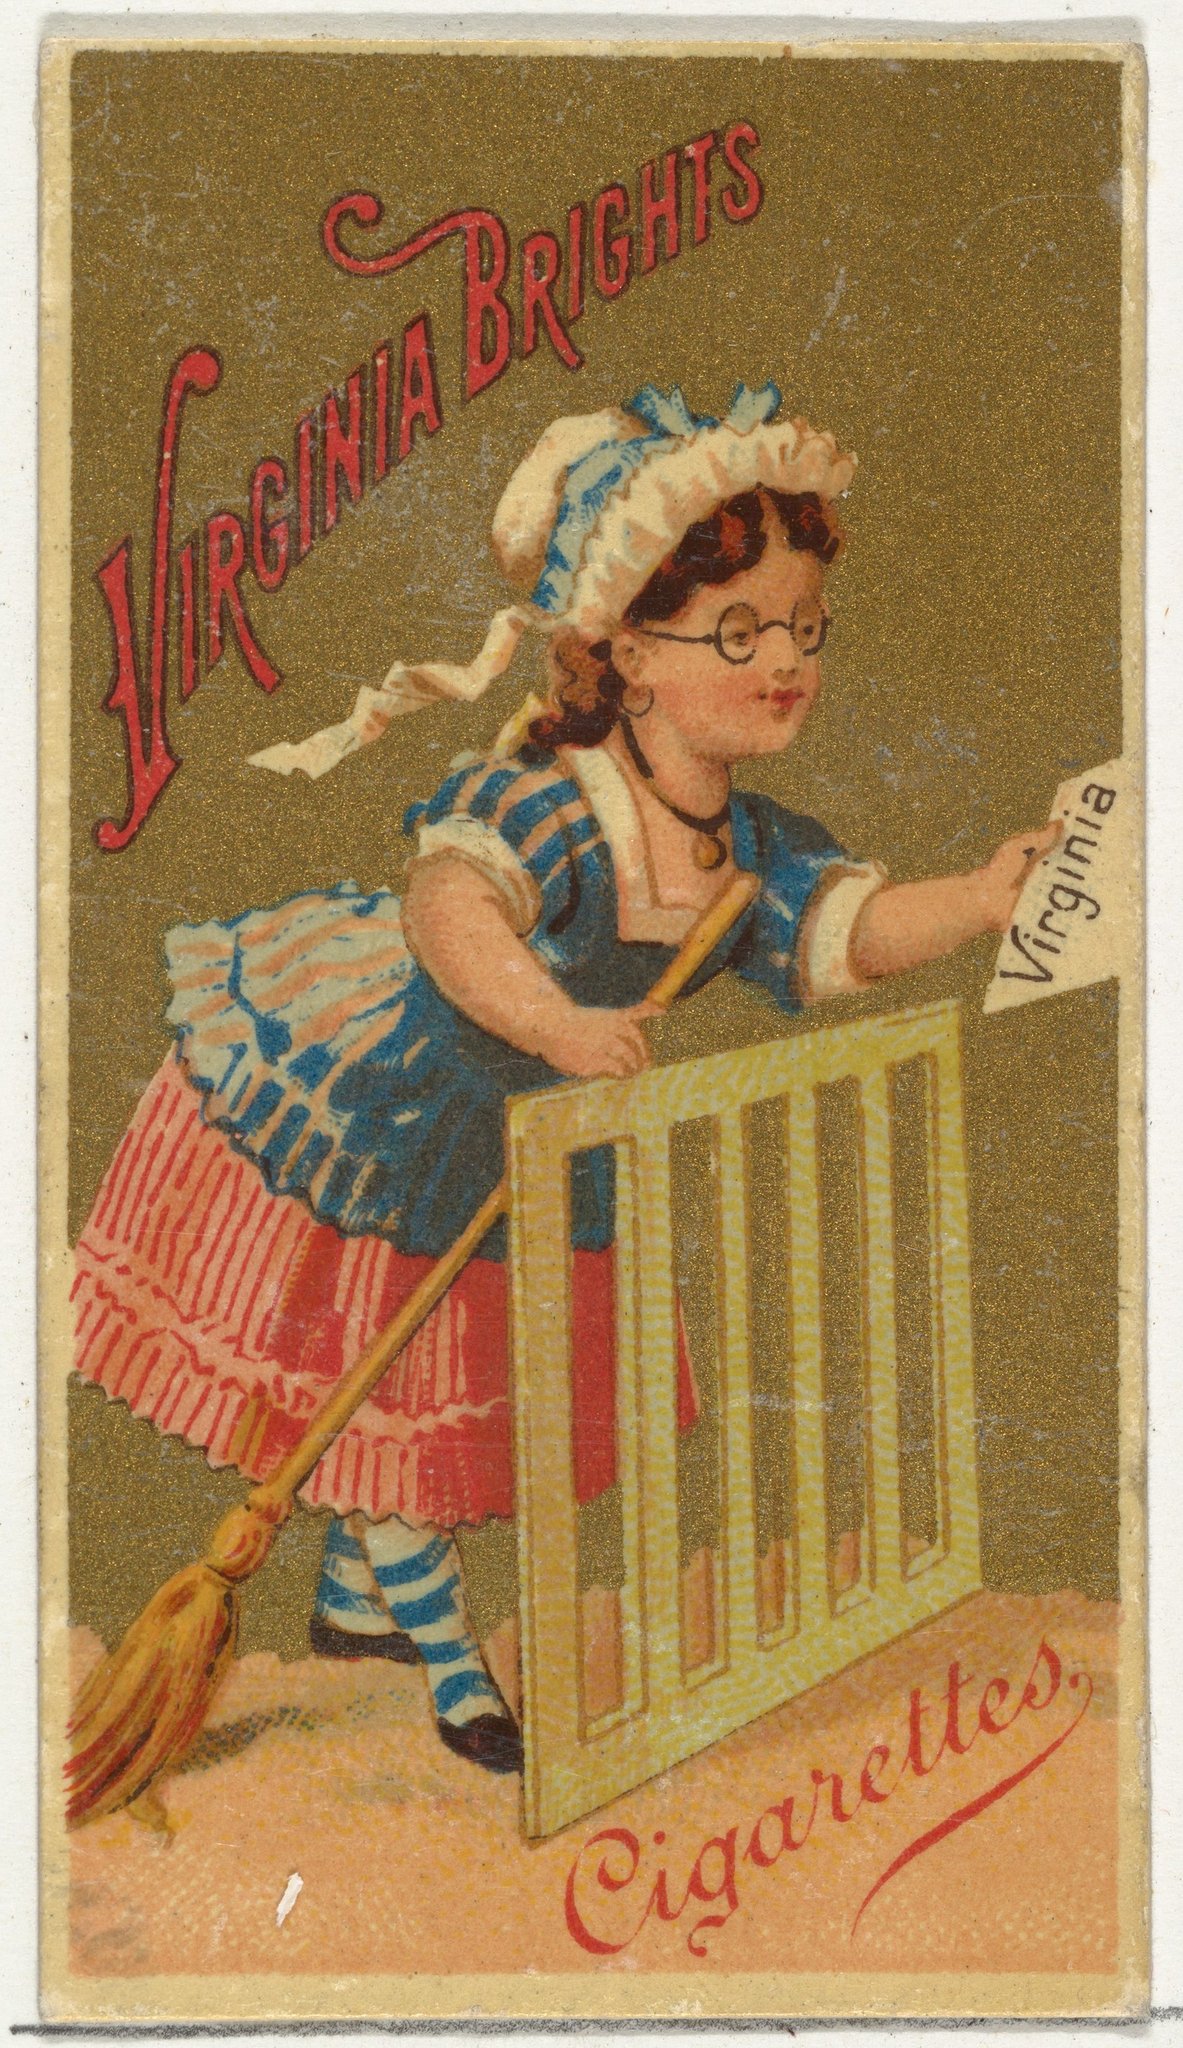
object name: print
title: From the Girls and Children series (N64) promoting Virginia Brights Cigarettes for Allen & Ginter brand tobacco products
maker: allen & ginter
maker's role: publisher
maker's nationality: american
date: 1886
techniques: color lithograph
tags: girls